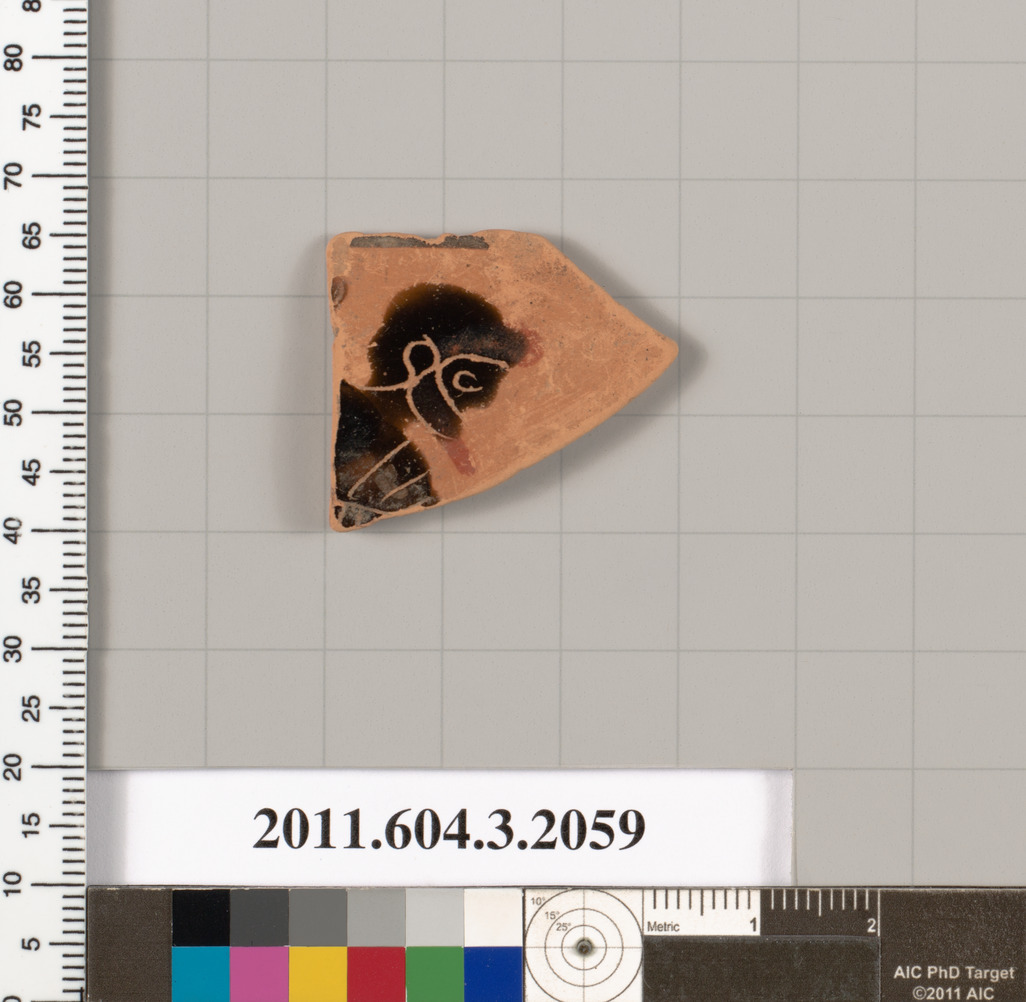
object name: kylix fragment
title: Terracotta rim fragment of a kylix (drinking cup)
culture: greek, attic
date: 500-480 BCE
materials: terracotta